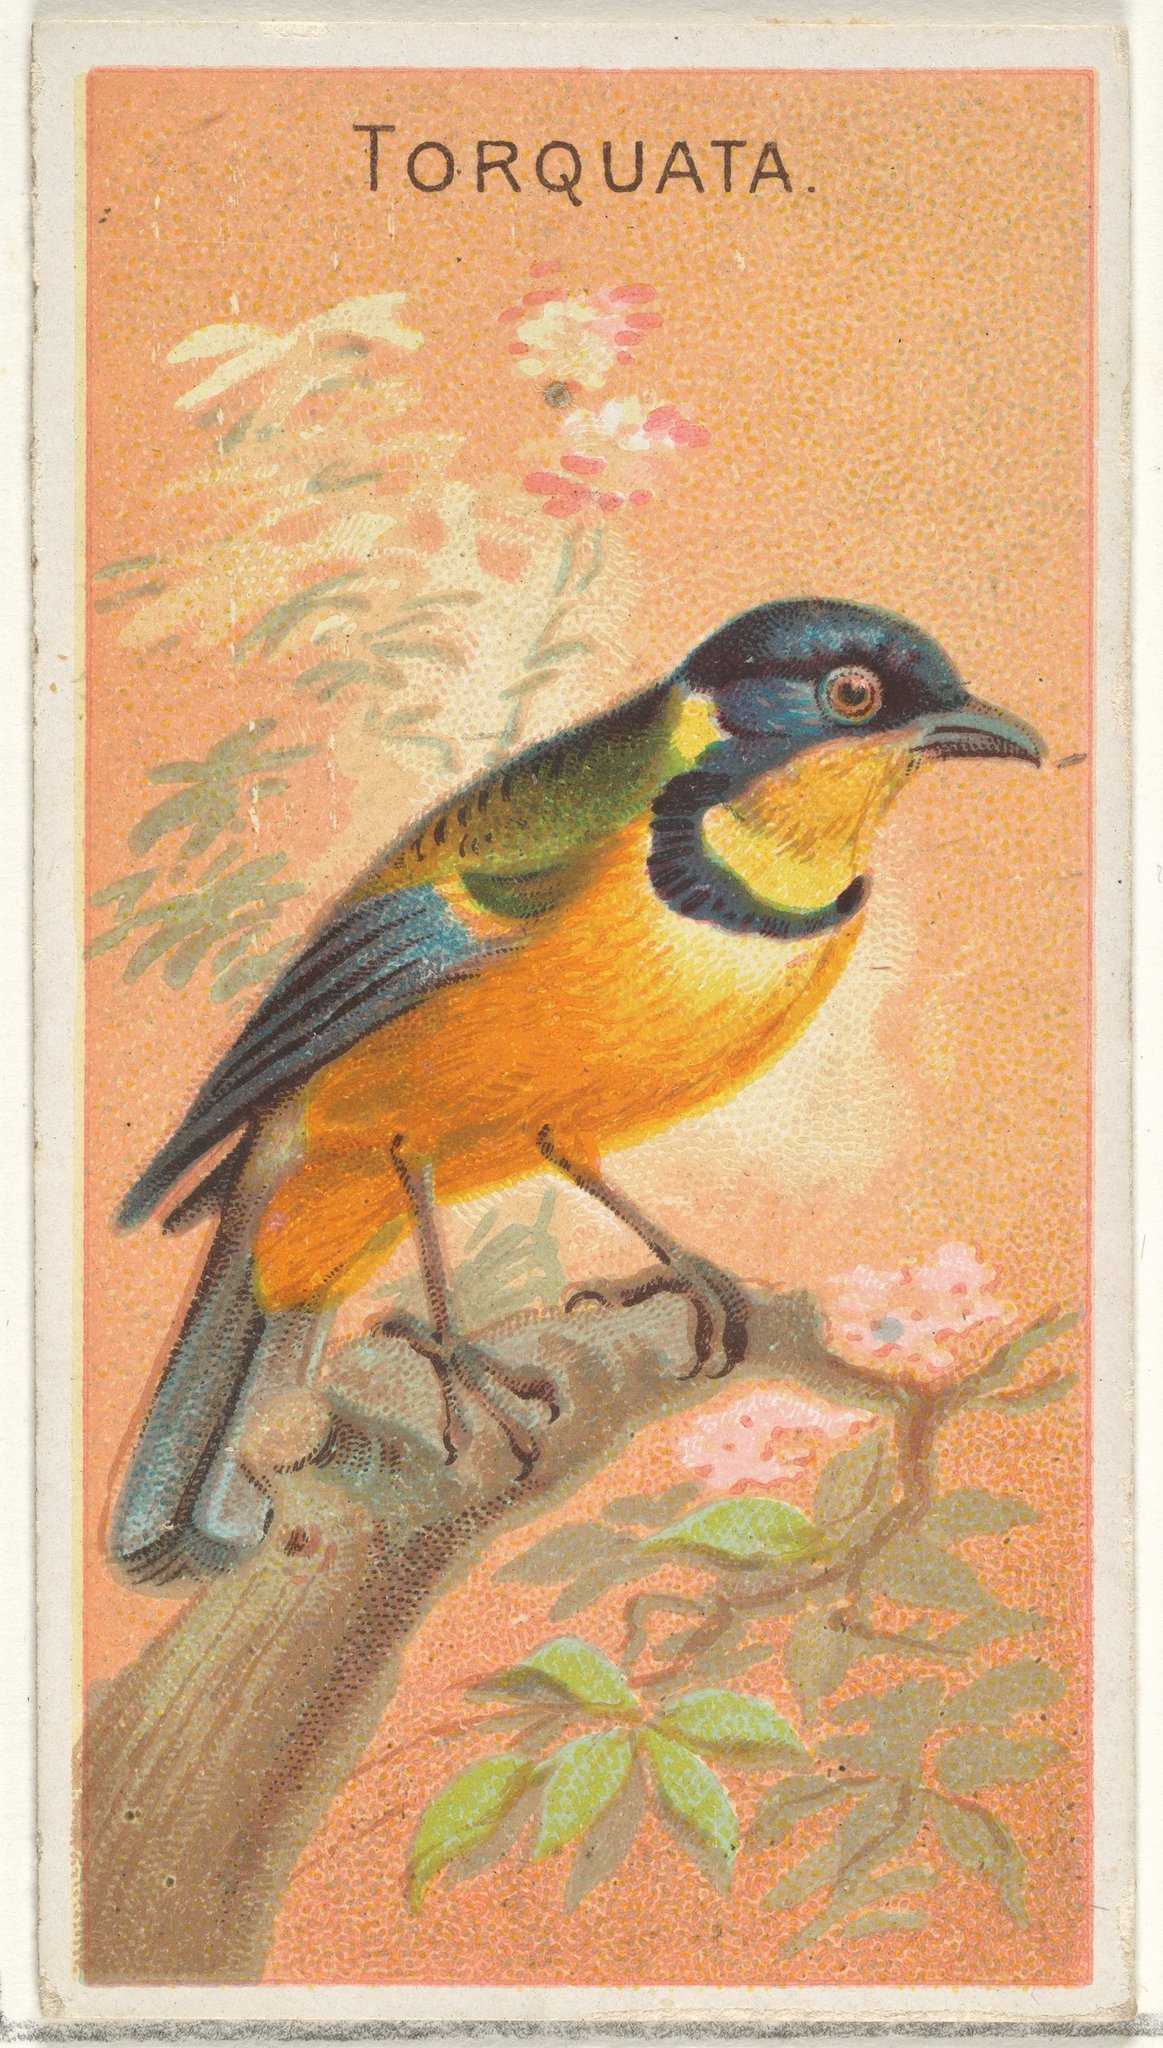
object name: print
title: Torquata, from the Birds of the Tropics series (N5) for Allen & Ginter Cigarettes Brands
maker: allen & ginter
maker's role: publisher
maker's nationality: american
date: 1889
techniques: color lithograph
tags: birds